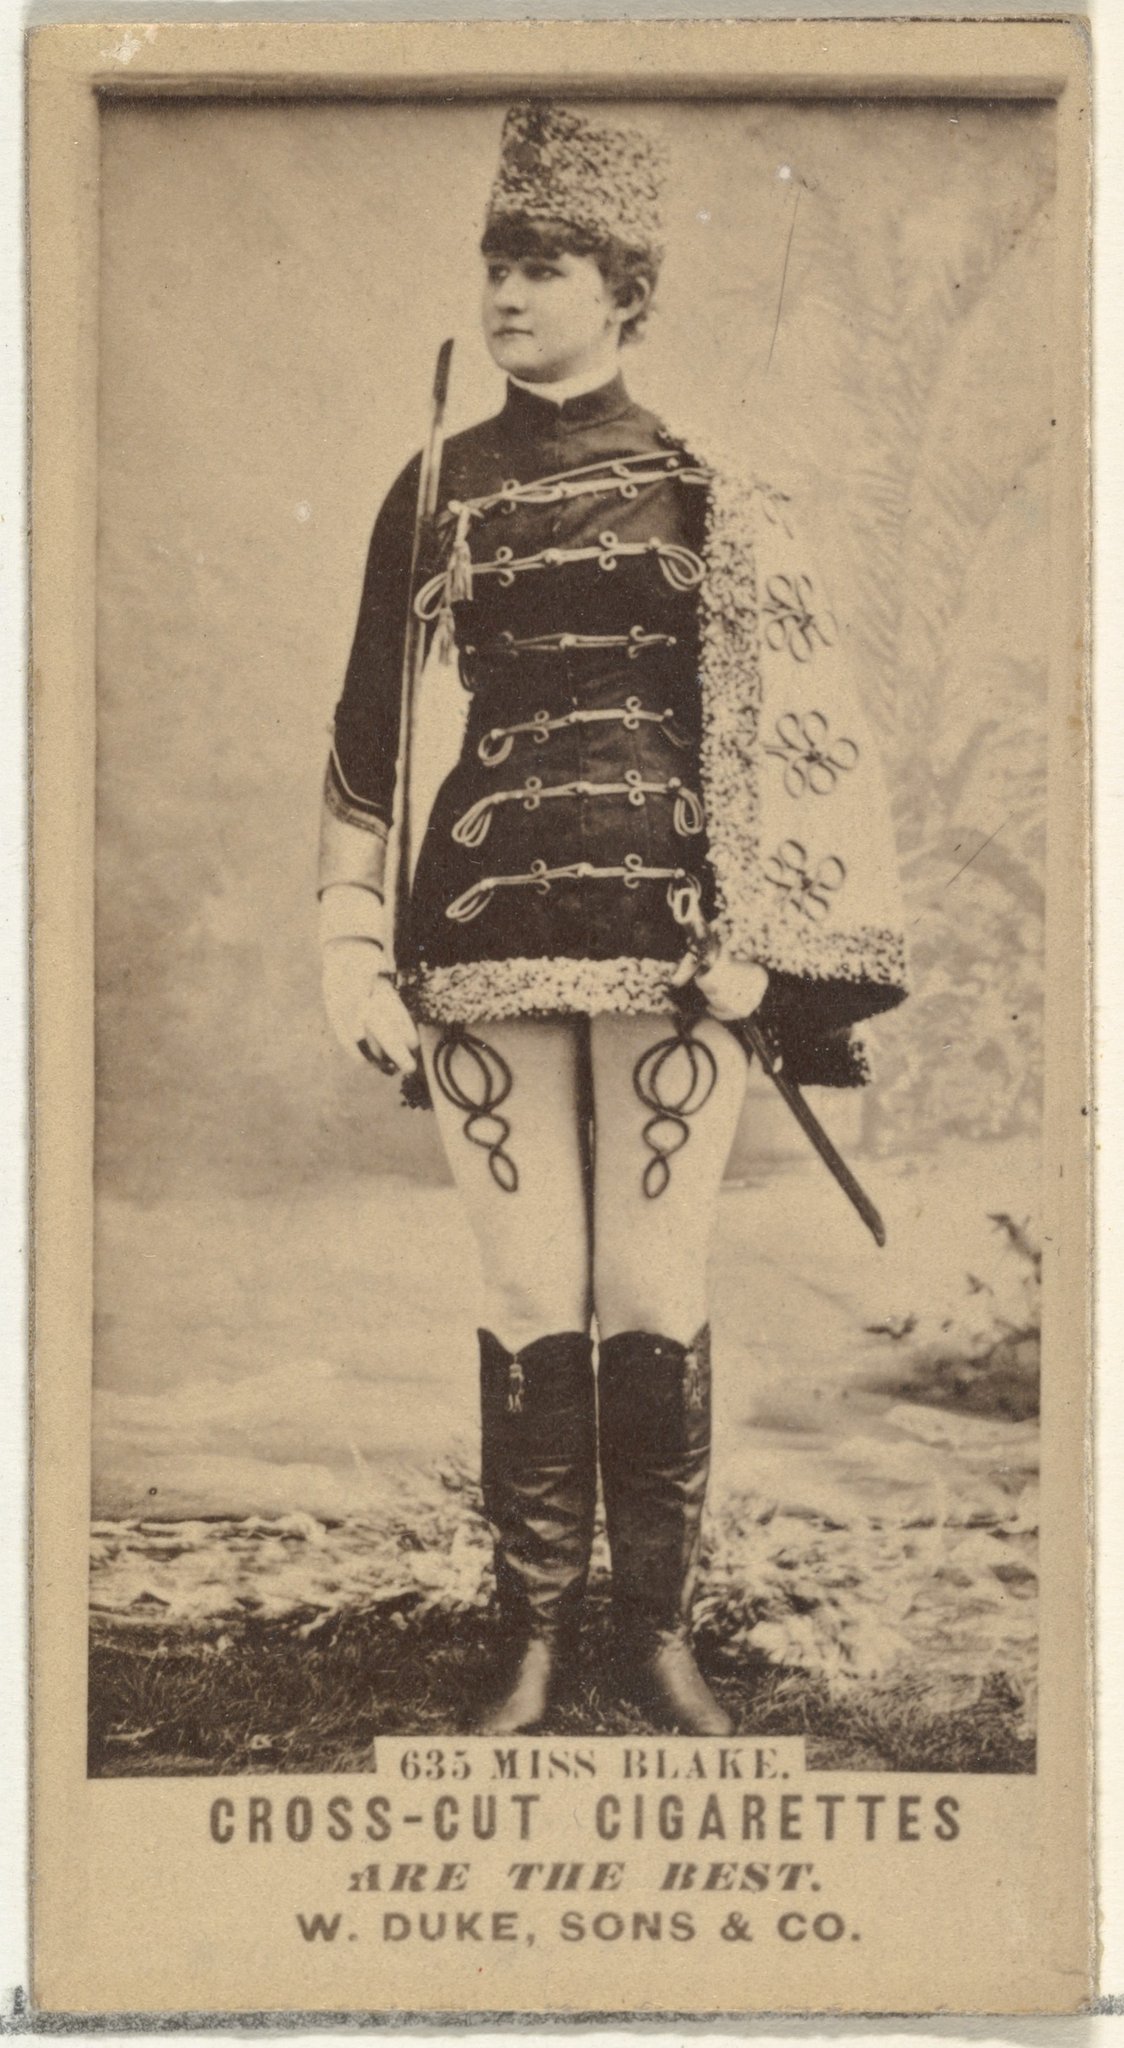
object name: photograph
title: Card Number 635, Miss Blake, from the Actors and Actresses series (N145-3) issued by Duke Sons & Co. to promote Cross Cut Cigarettes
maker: w. duke, sons & co.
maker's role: publisher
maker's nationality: american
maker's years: 1870-1920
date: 1880-1889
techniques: albumen silver print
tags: portraits,women,actresses